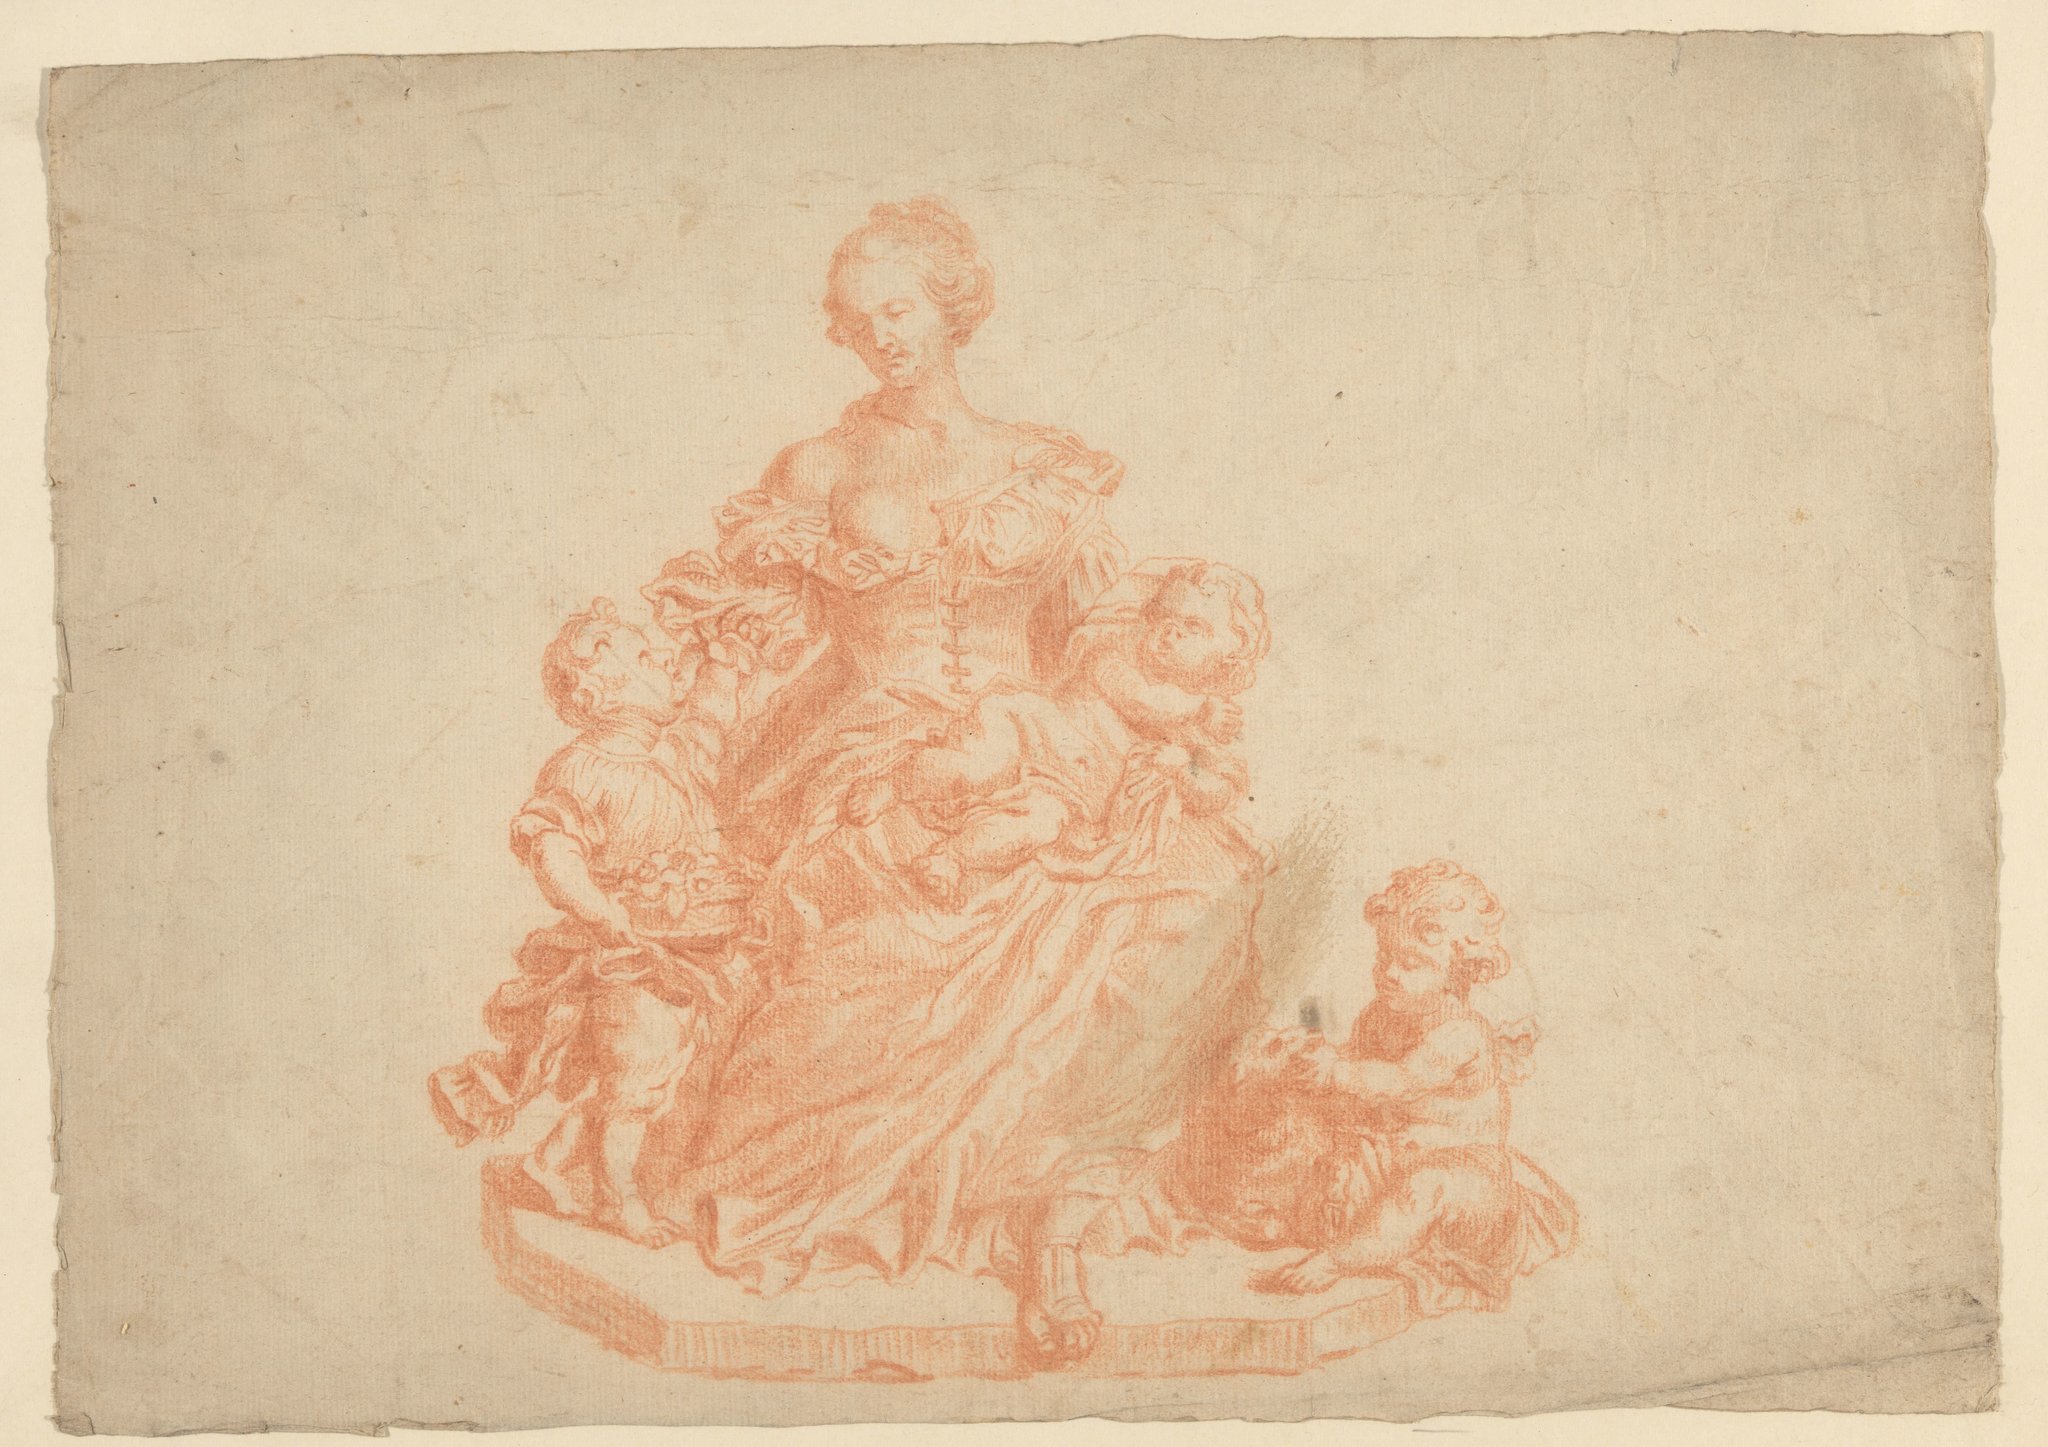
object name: drawing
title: Zittende vrouw met drie kinderen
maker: Anonymous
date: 1700-1800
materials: chalk, paper